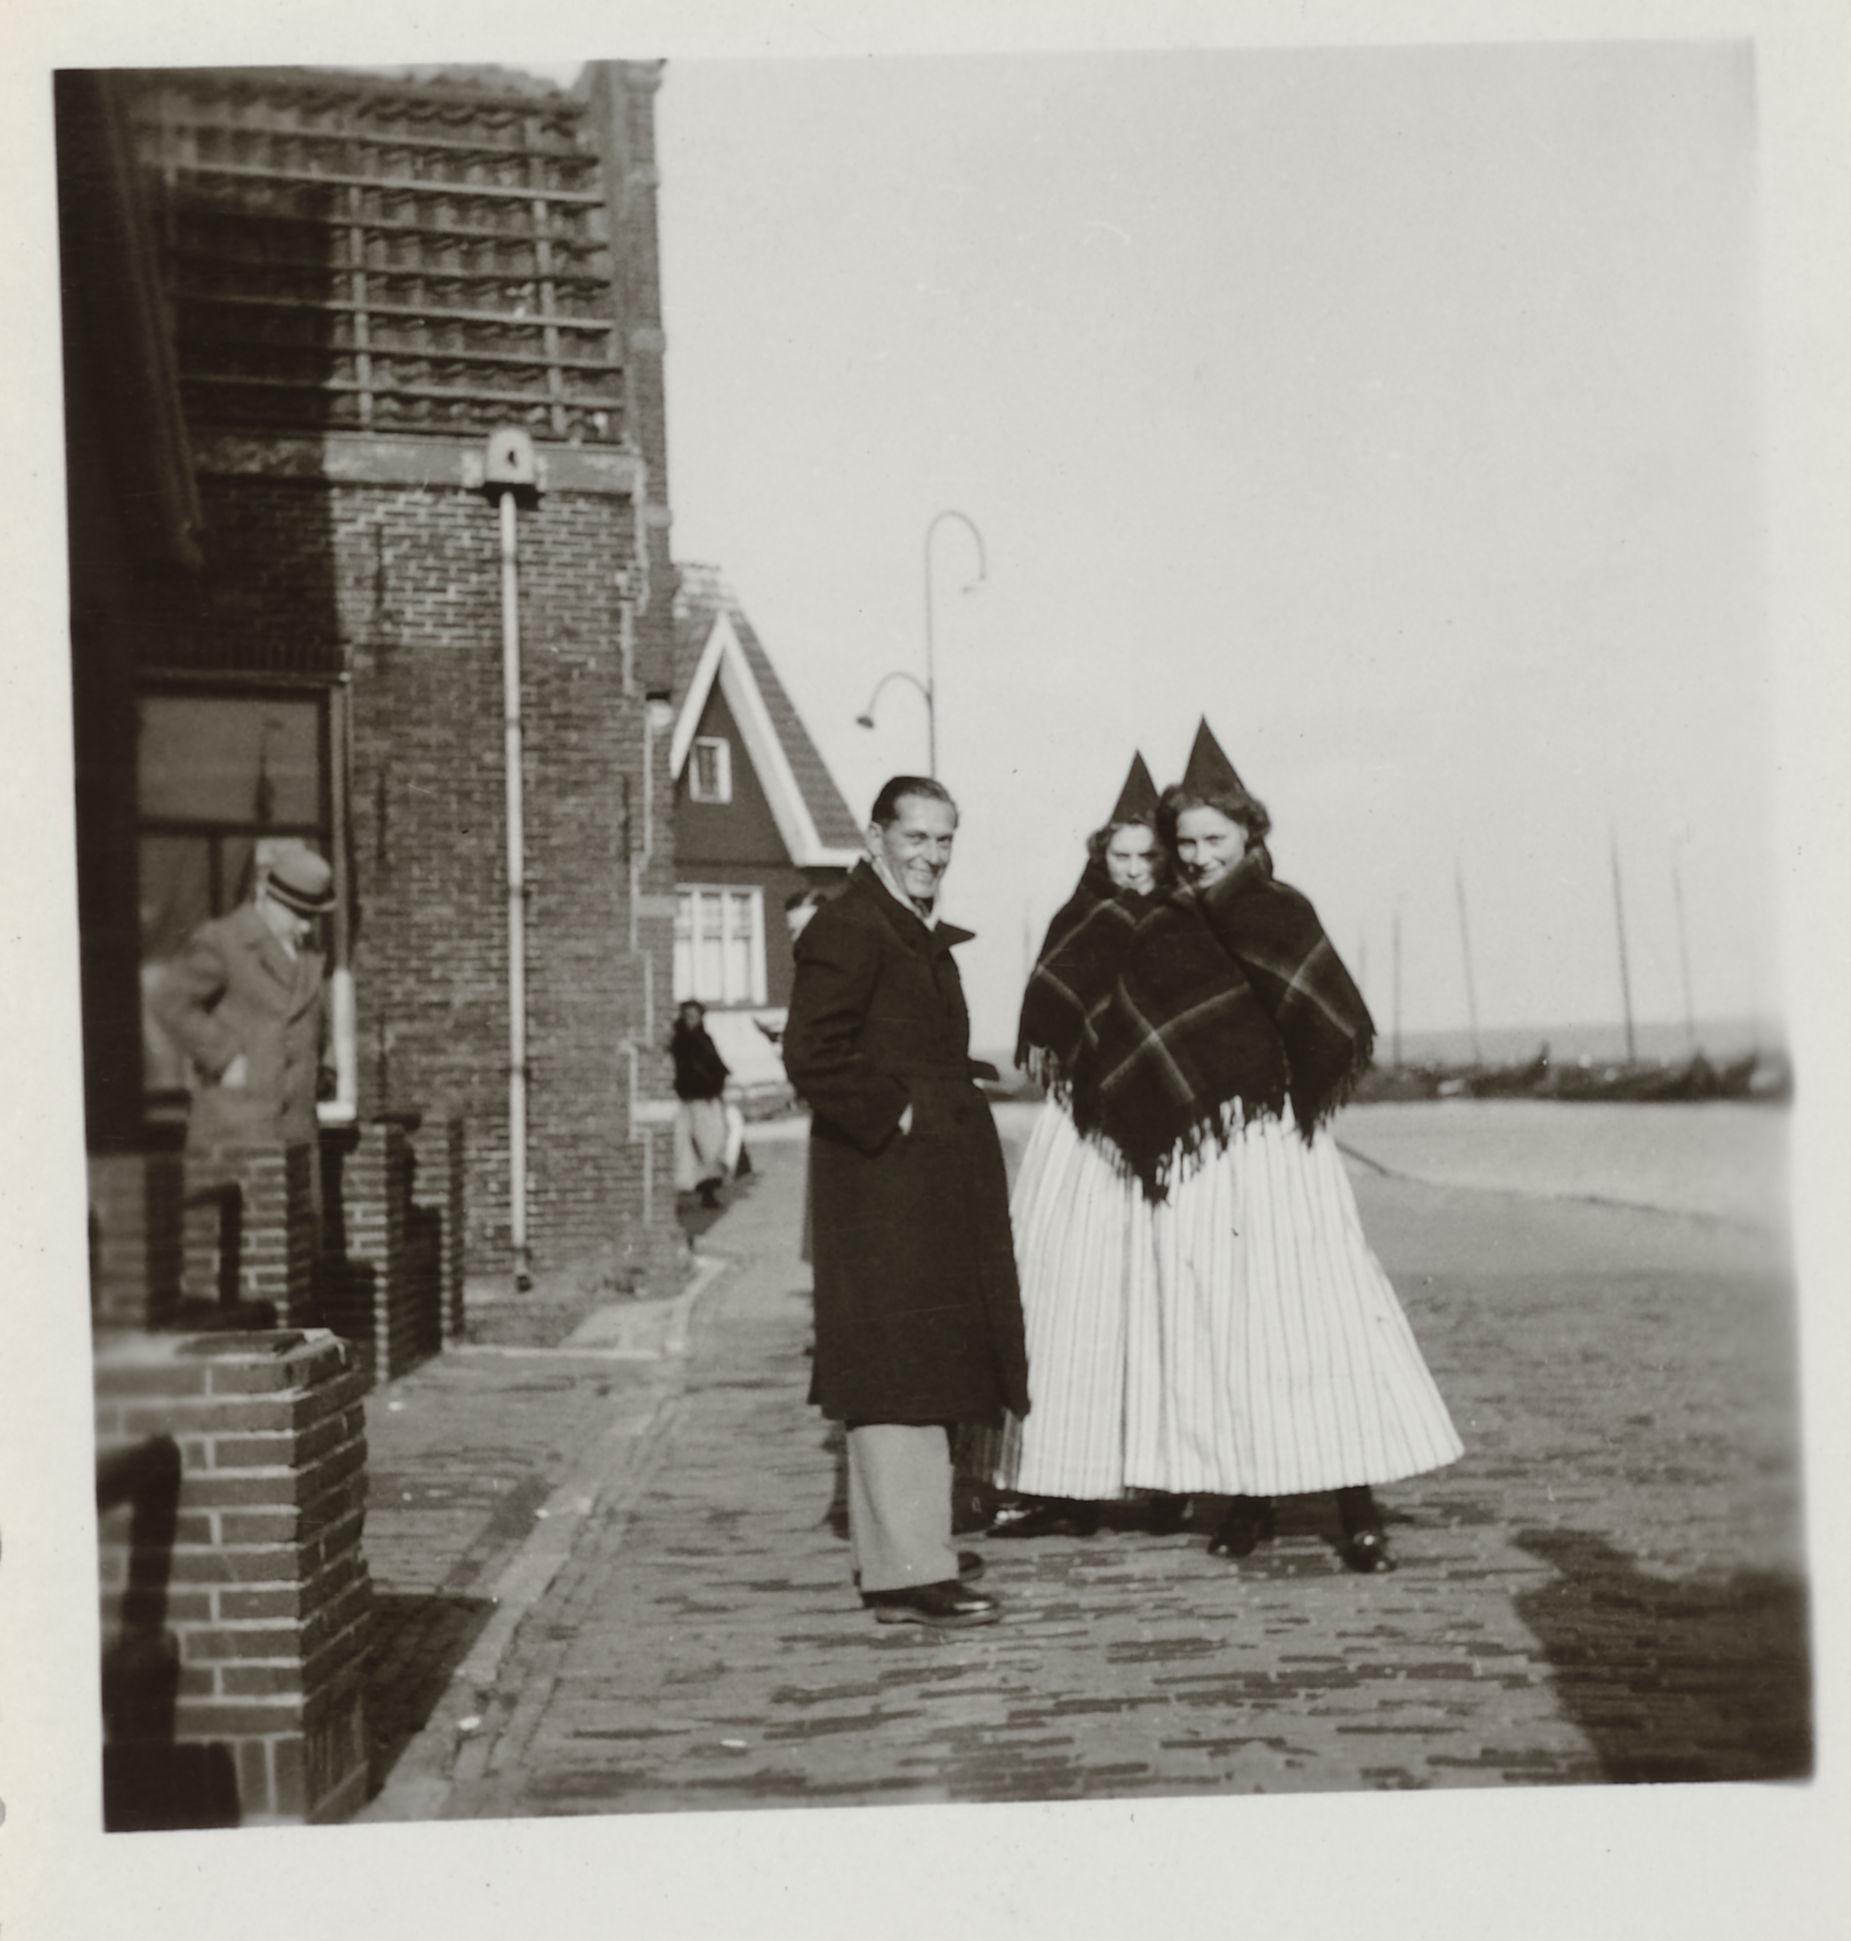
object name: photograph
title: Gideon Elon, de derde echtgenoot van Isabel Wachenheimer, in een Nederlandse stad naast twee vrouwen in Nederlandse klederdracht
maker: Anonymous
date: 1956-1970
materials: photographic support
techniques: gelatin silver print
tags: gideon elon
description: Gideon Elon, de derde echtgenoot van Isabel Wachenheimer, in een Nederlandse stad naast twee vrouwen in Nederlandse klederdracht.